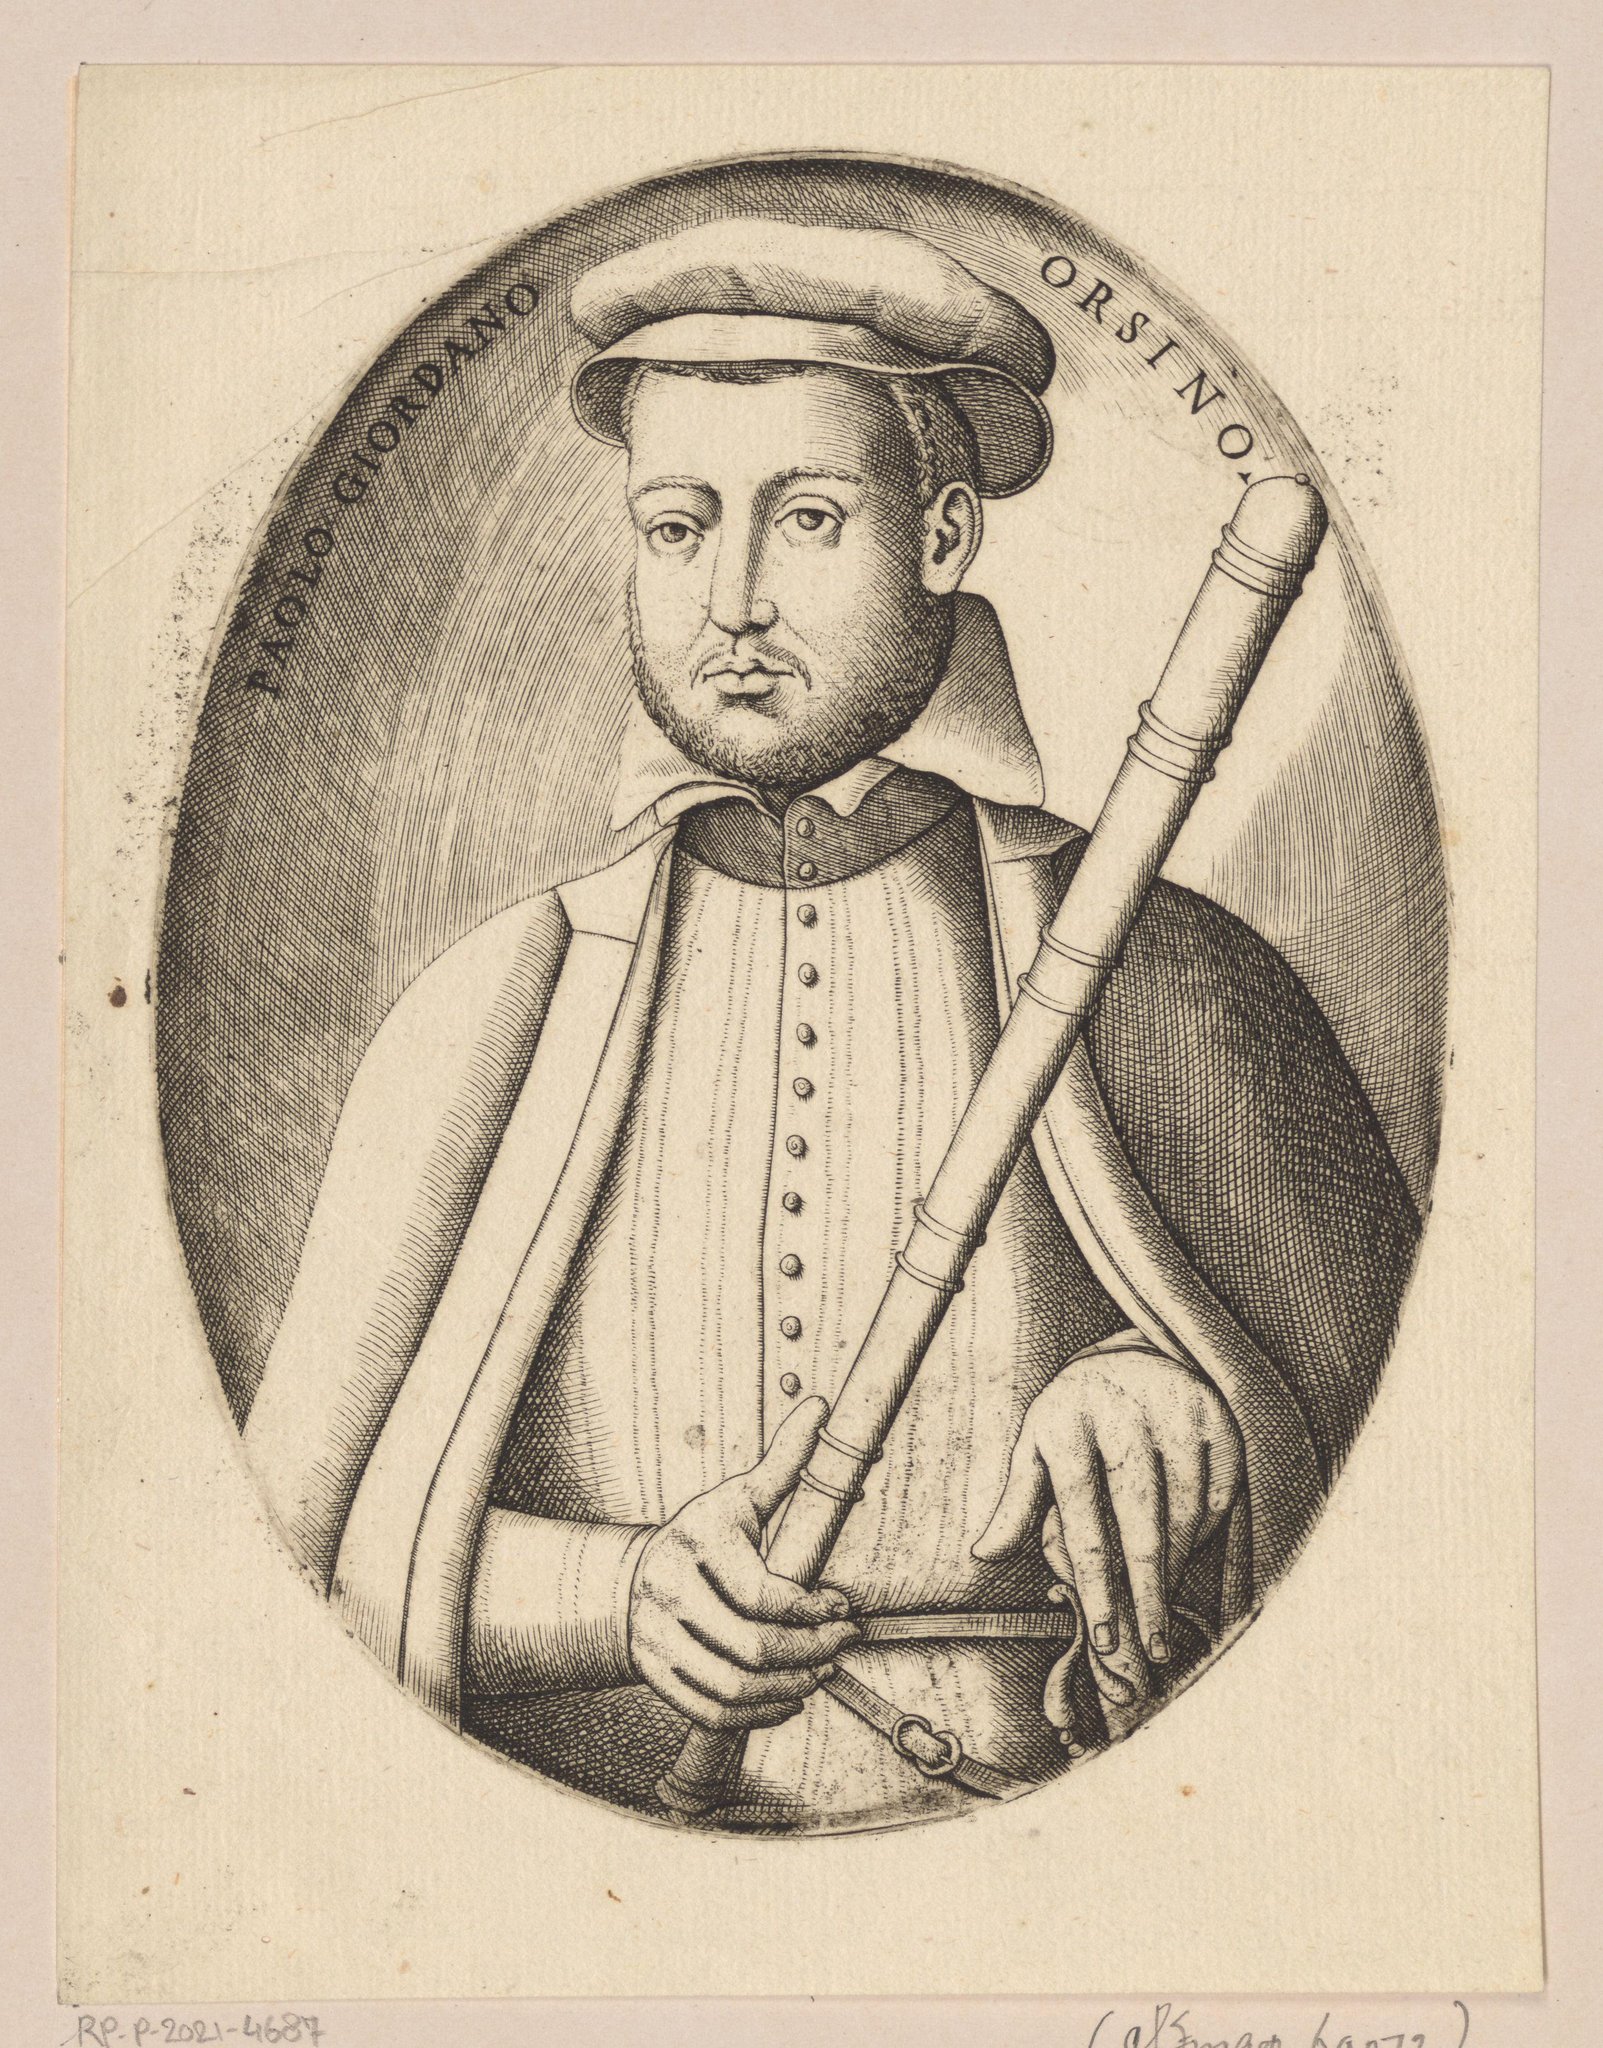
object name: print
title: Portret van Paulo Giordano I Orsini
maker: Anonymous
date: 1565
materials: paper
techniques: engraving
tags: paulo giordano i orsini, historical persons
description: Prent met omlijsting gebruikt in: Sansovino, Francesco. L'Historia di Casa Orsina di Francesco Sansovino. Venetië: Filippo en Bernardino Stagnino, 1565.